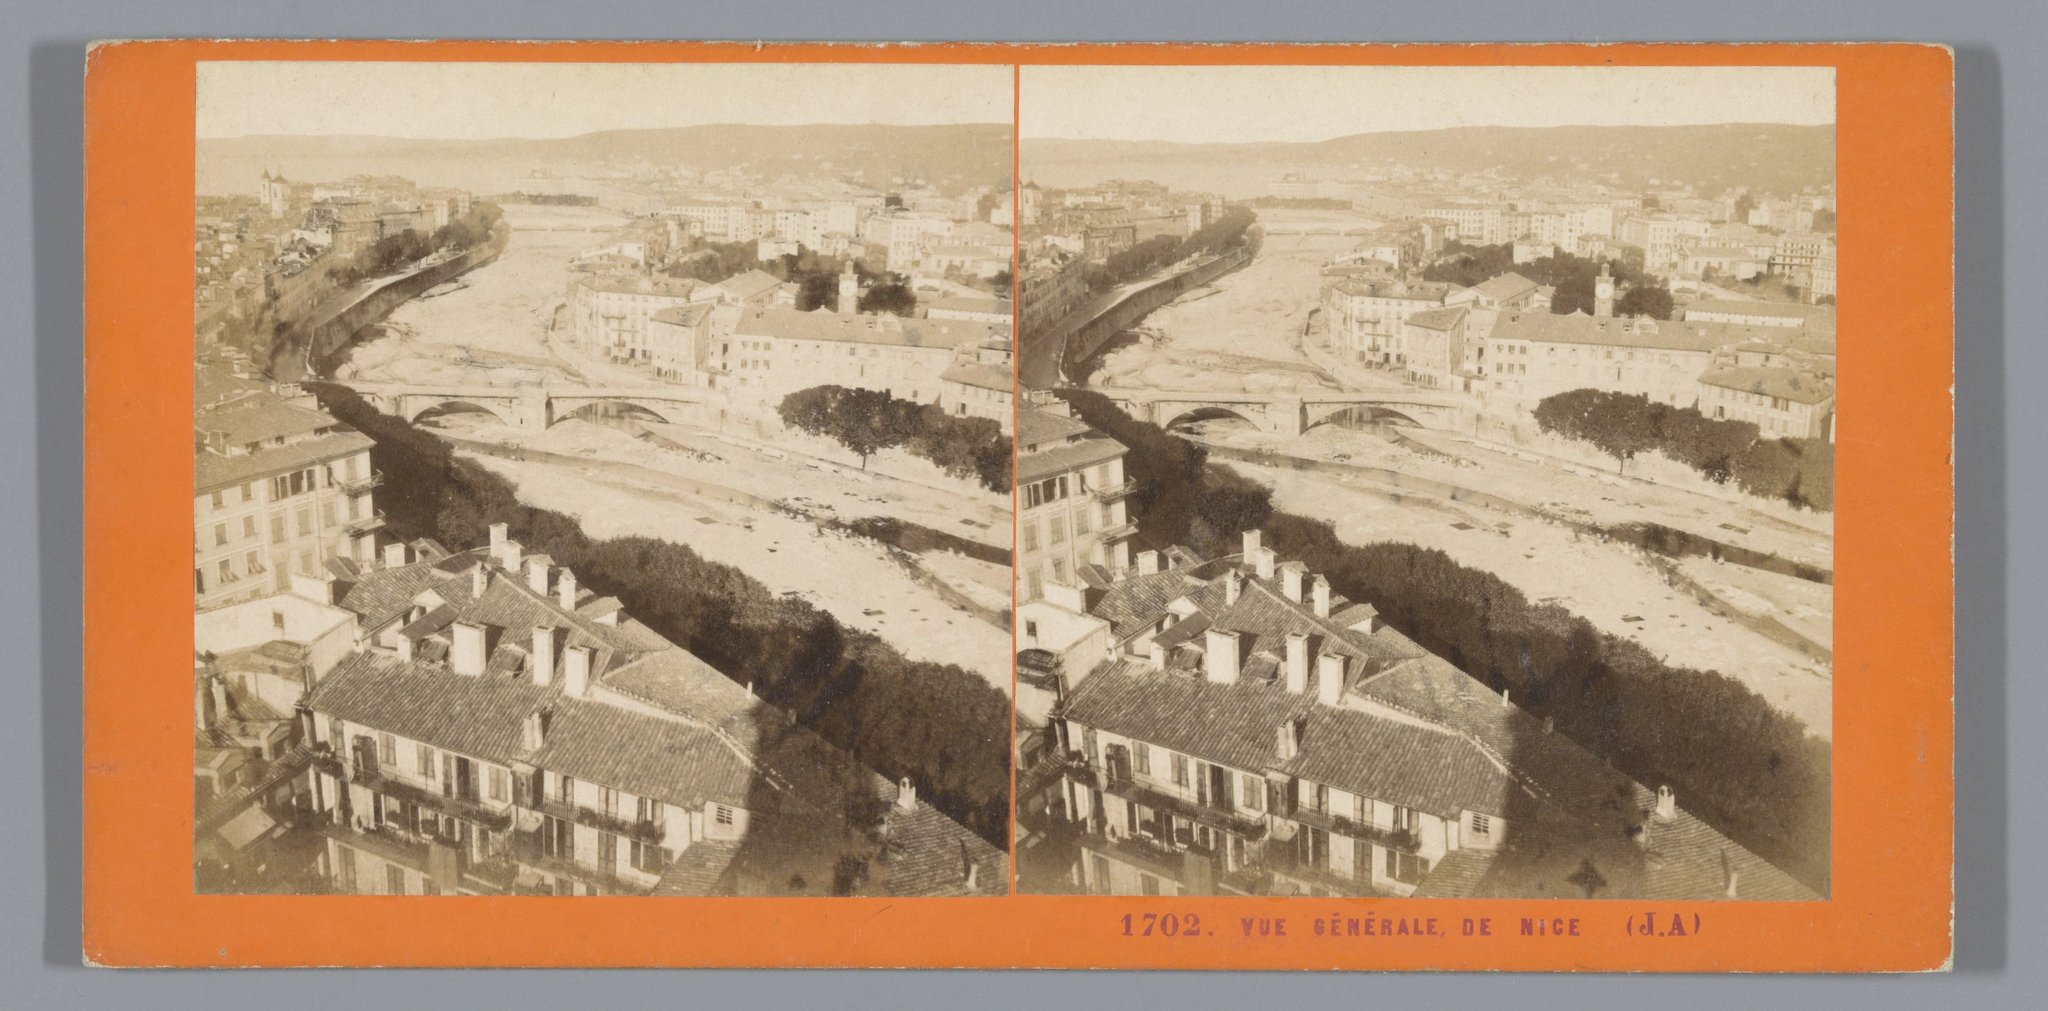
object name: stereograph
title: Vue générale, de Nice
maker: jean andrieu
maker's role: fotograaf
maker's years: 1816-1872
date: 1865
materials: cardboard, photographic support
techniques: albumen print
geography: nice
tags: city-view, and landscape with man-made constructions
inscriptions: number: ‘1702.’, inscription: ‘10126 no’